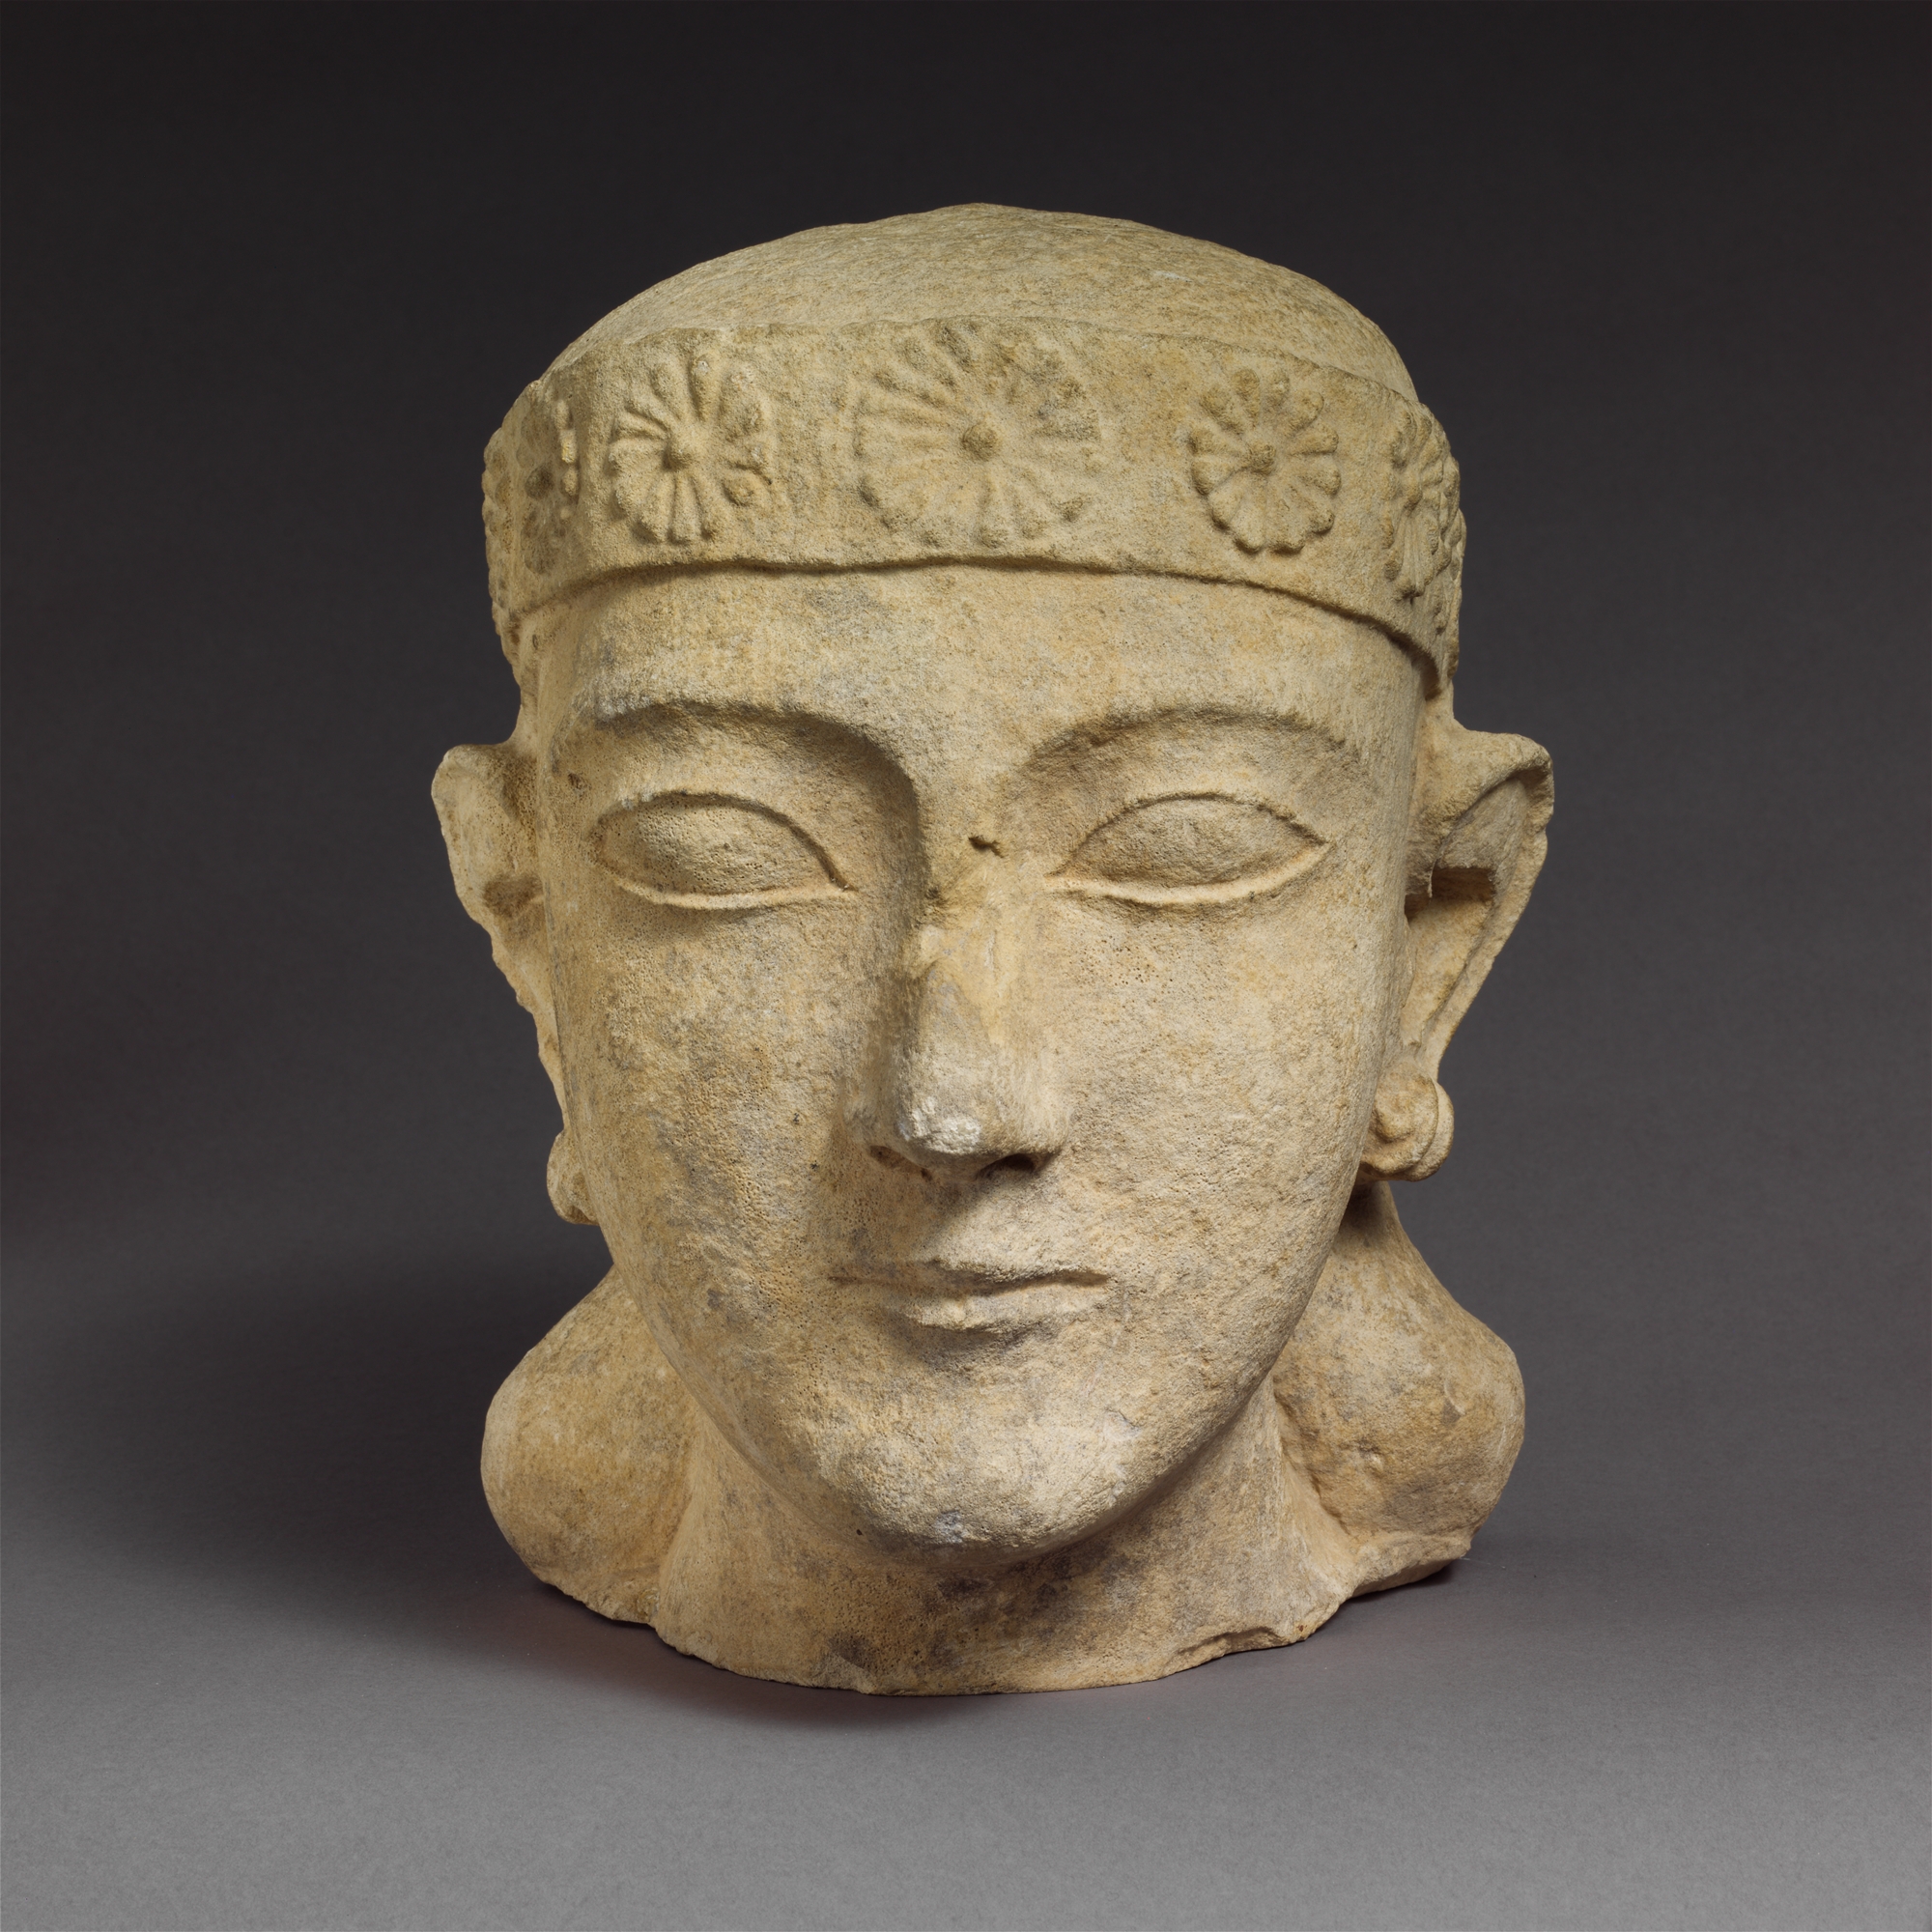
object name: head of a male votary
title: Limestone head of a beardless male with a diadem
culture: cypriot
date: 567-535 BCE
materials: limestone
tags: diadems,heads,men